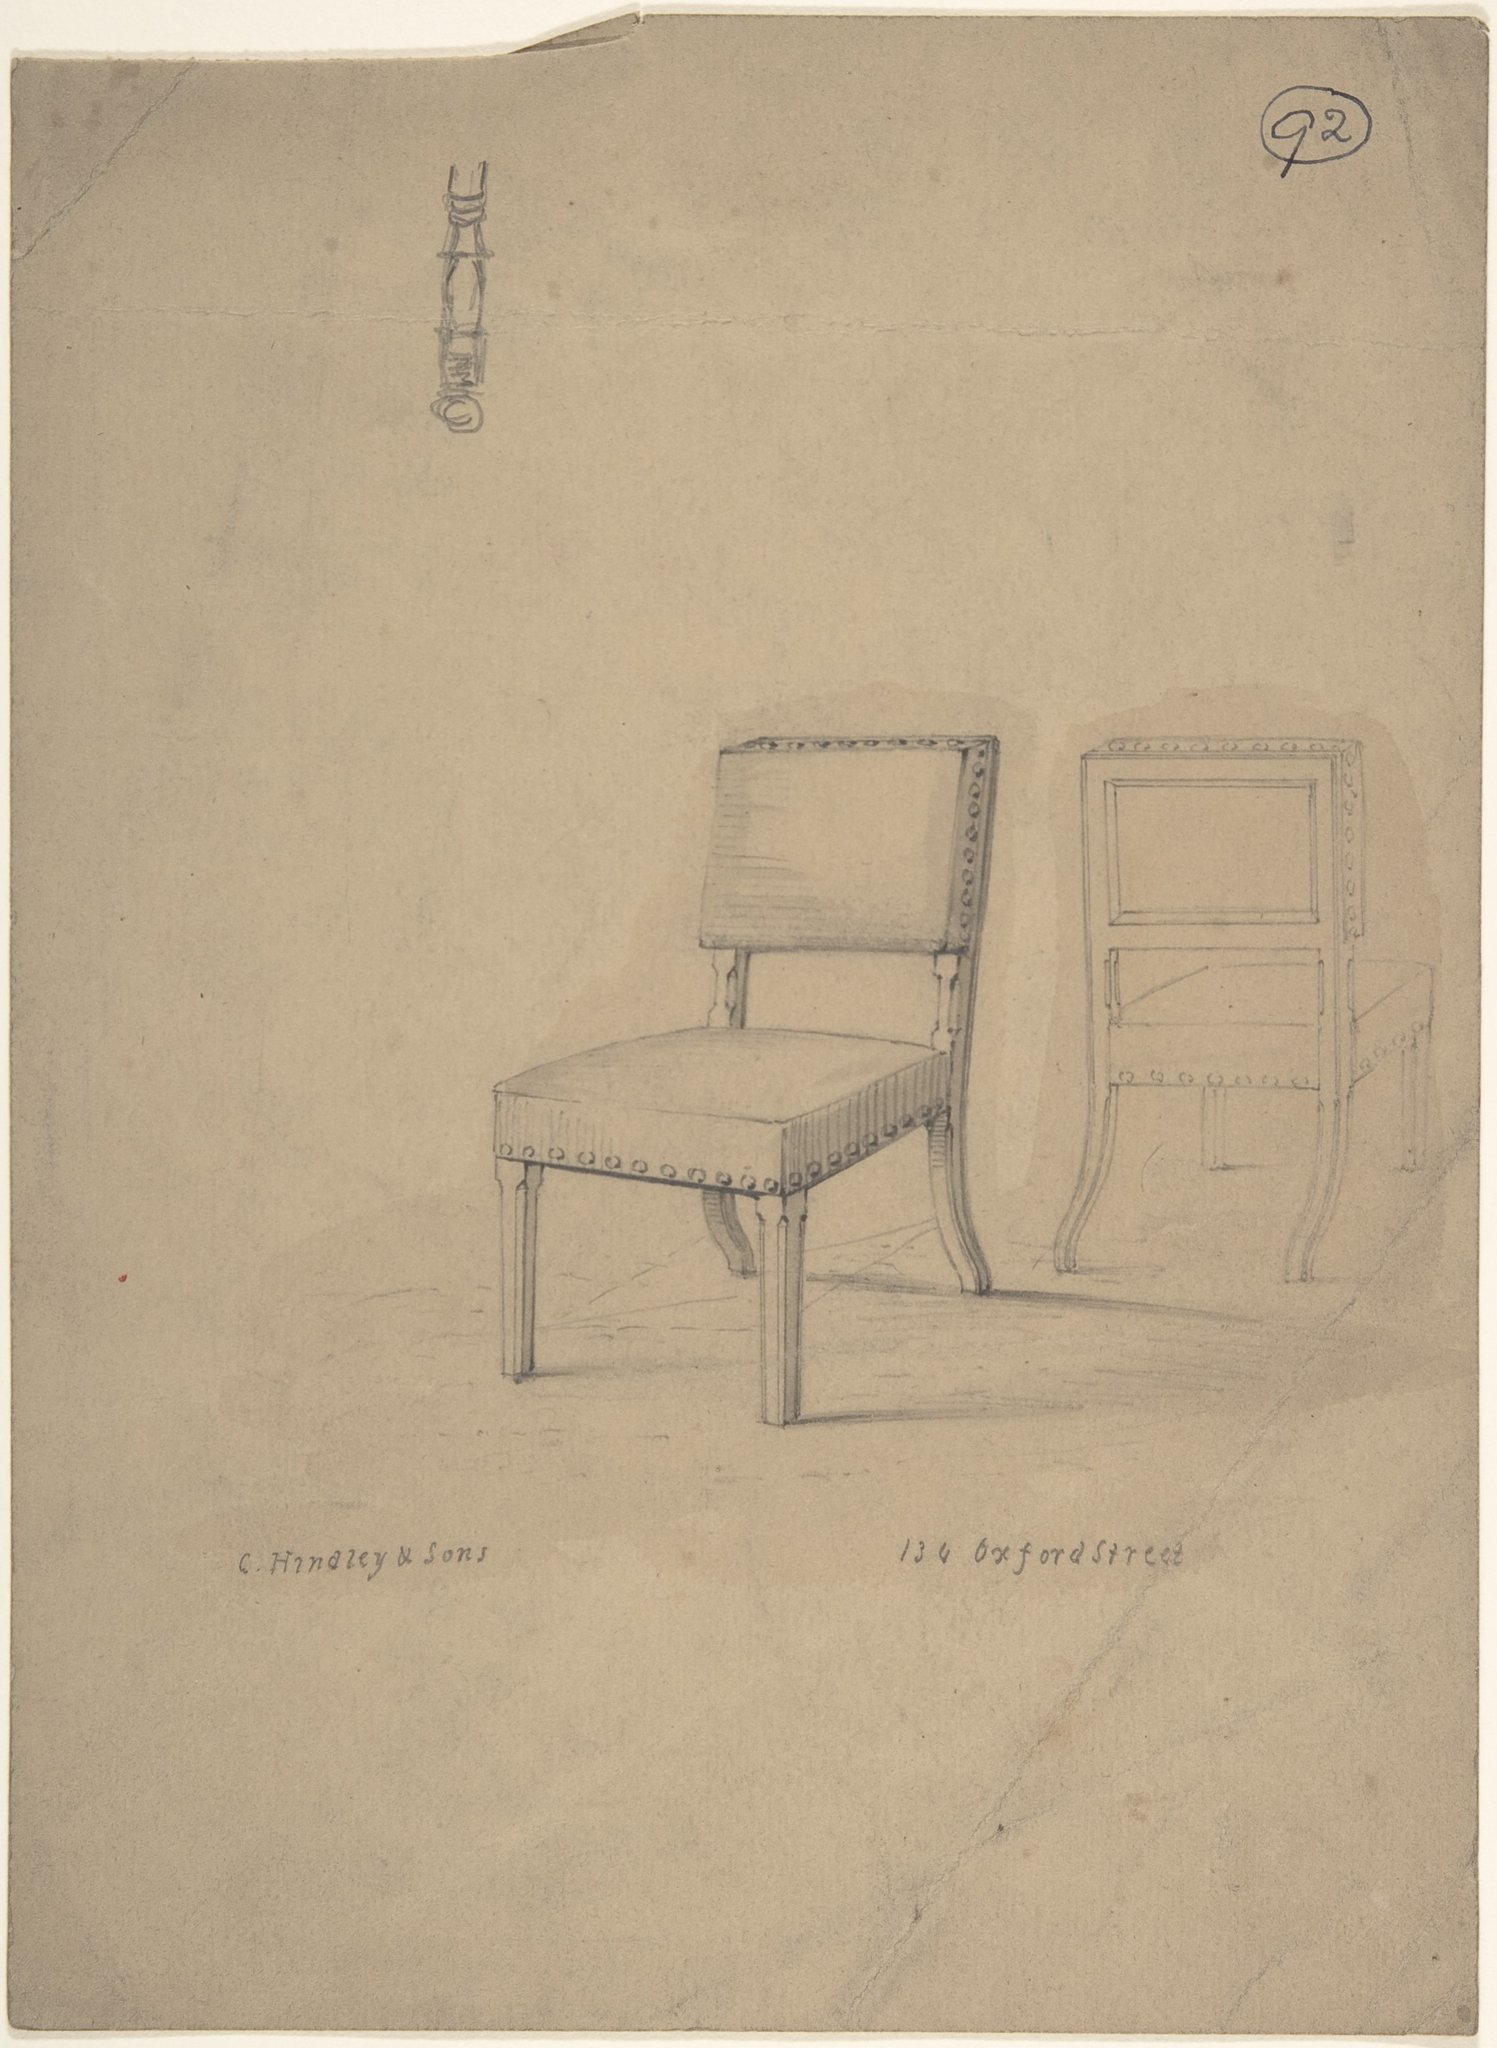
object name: drawing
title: View of Front and Rear of Chair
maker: charles hindley and sons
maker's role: artist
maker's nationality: british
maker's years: 1841-1917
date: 1841-1884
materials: graphite, ink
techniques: brush, pen, wash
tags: chairs